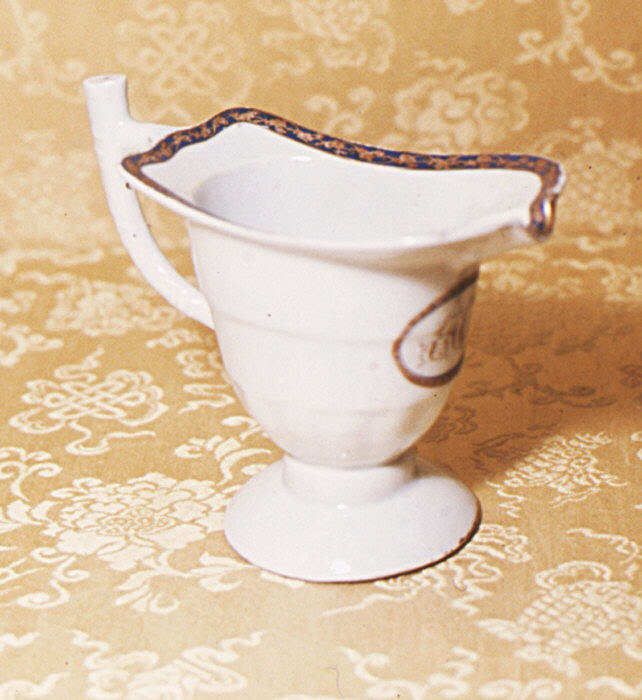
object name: creamer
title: Creamer (part of a service)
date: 1790-1800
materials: hard paste porcelain